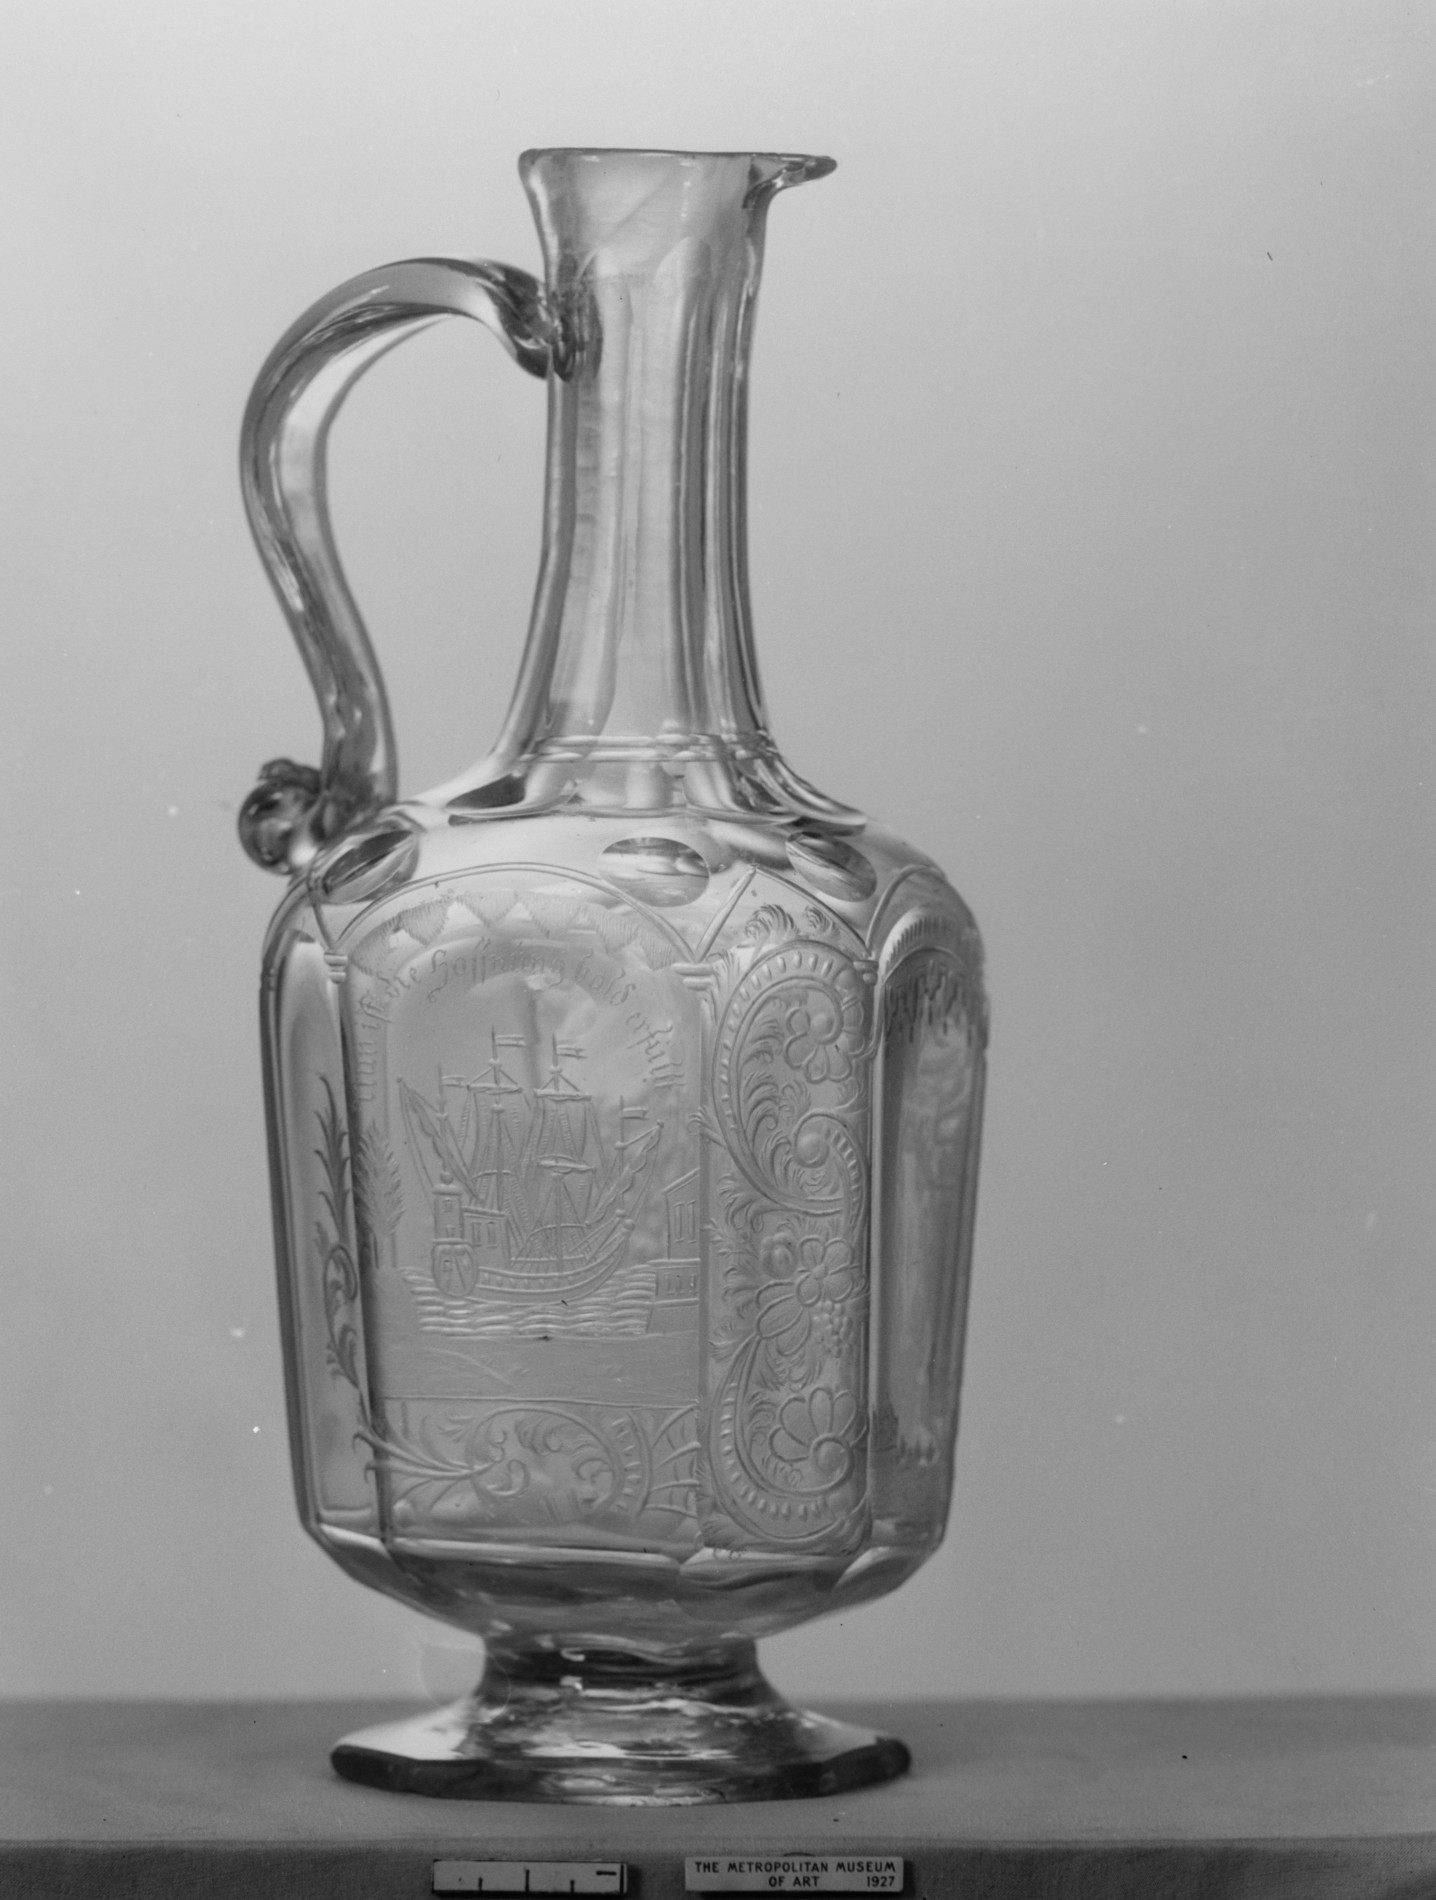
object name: ewer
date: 1745-1750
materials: glass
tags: flowers,ships